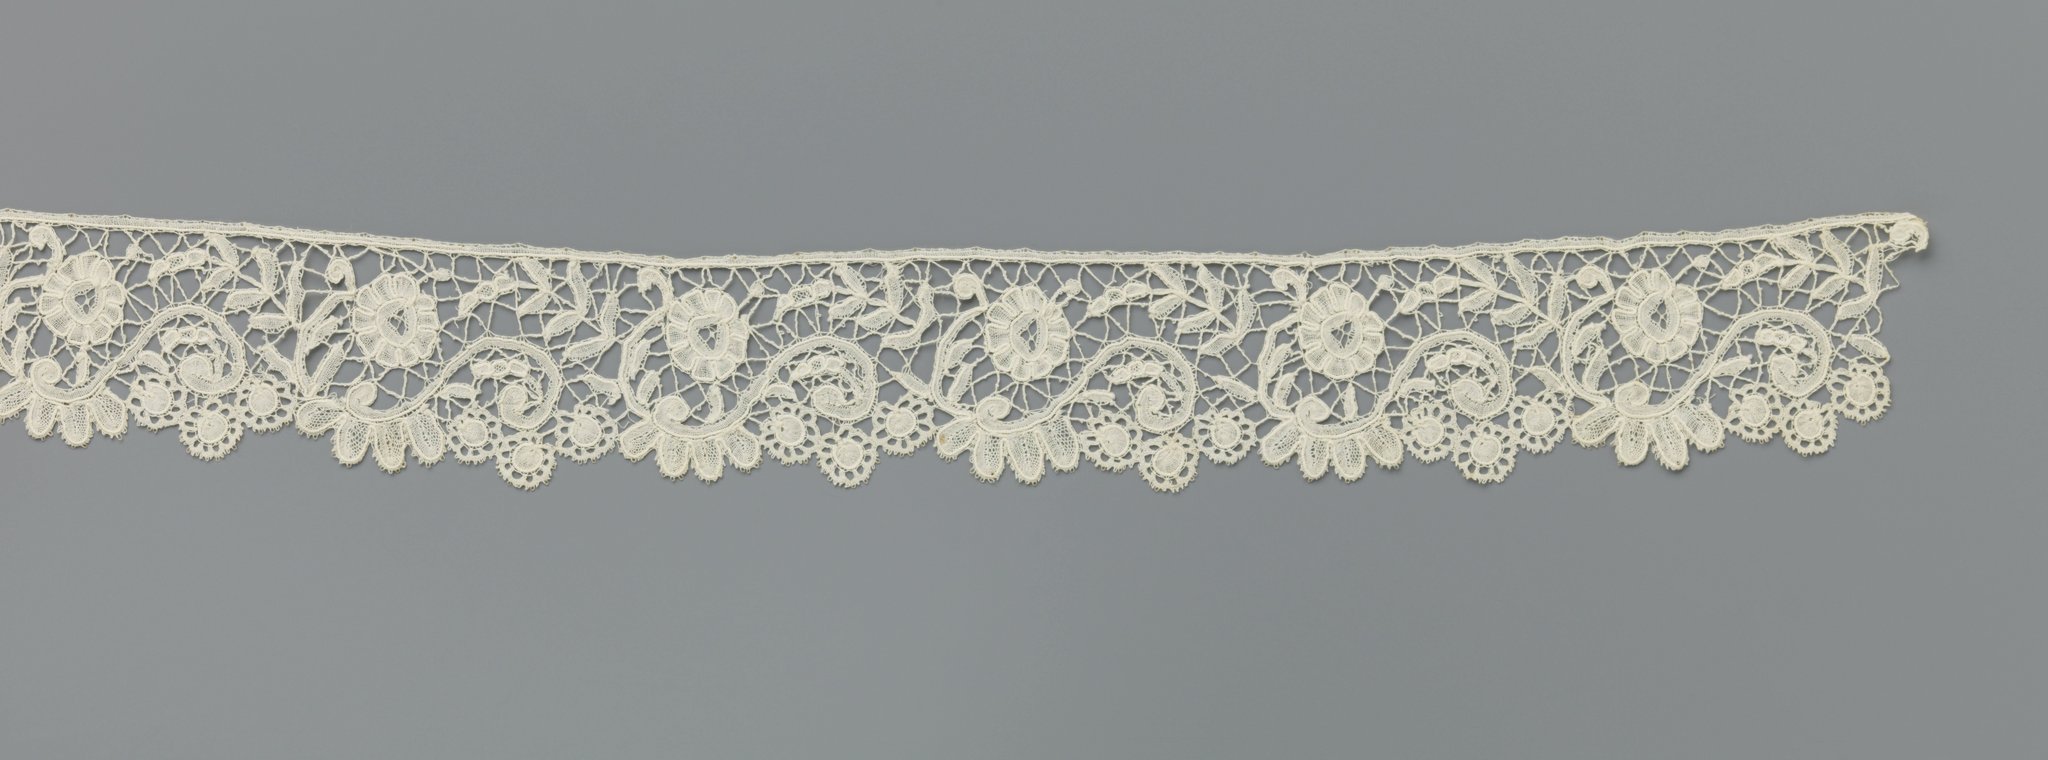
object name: strip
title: Strook kloskant met s-ranken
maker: Anonymous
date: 1875-1899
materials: linen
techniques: lace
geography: netherlands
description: Strook naturelkleurige kloskant: duchesse-kant. Op een vlechtengrond staat een lopend patroon. S-ranken met een drietal madeliefjes en een randje van campanes vormen de schulpen en eindigen in een voluut met enkelvoudig roosje.